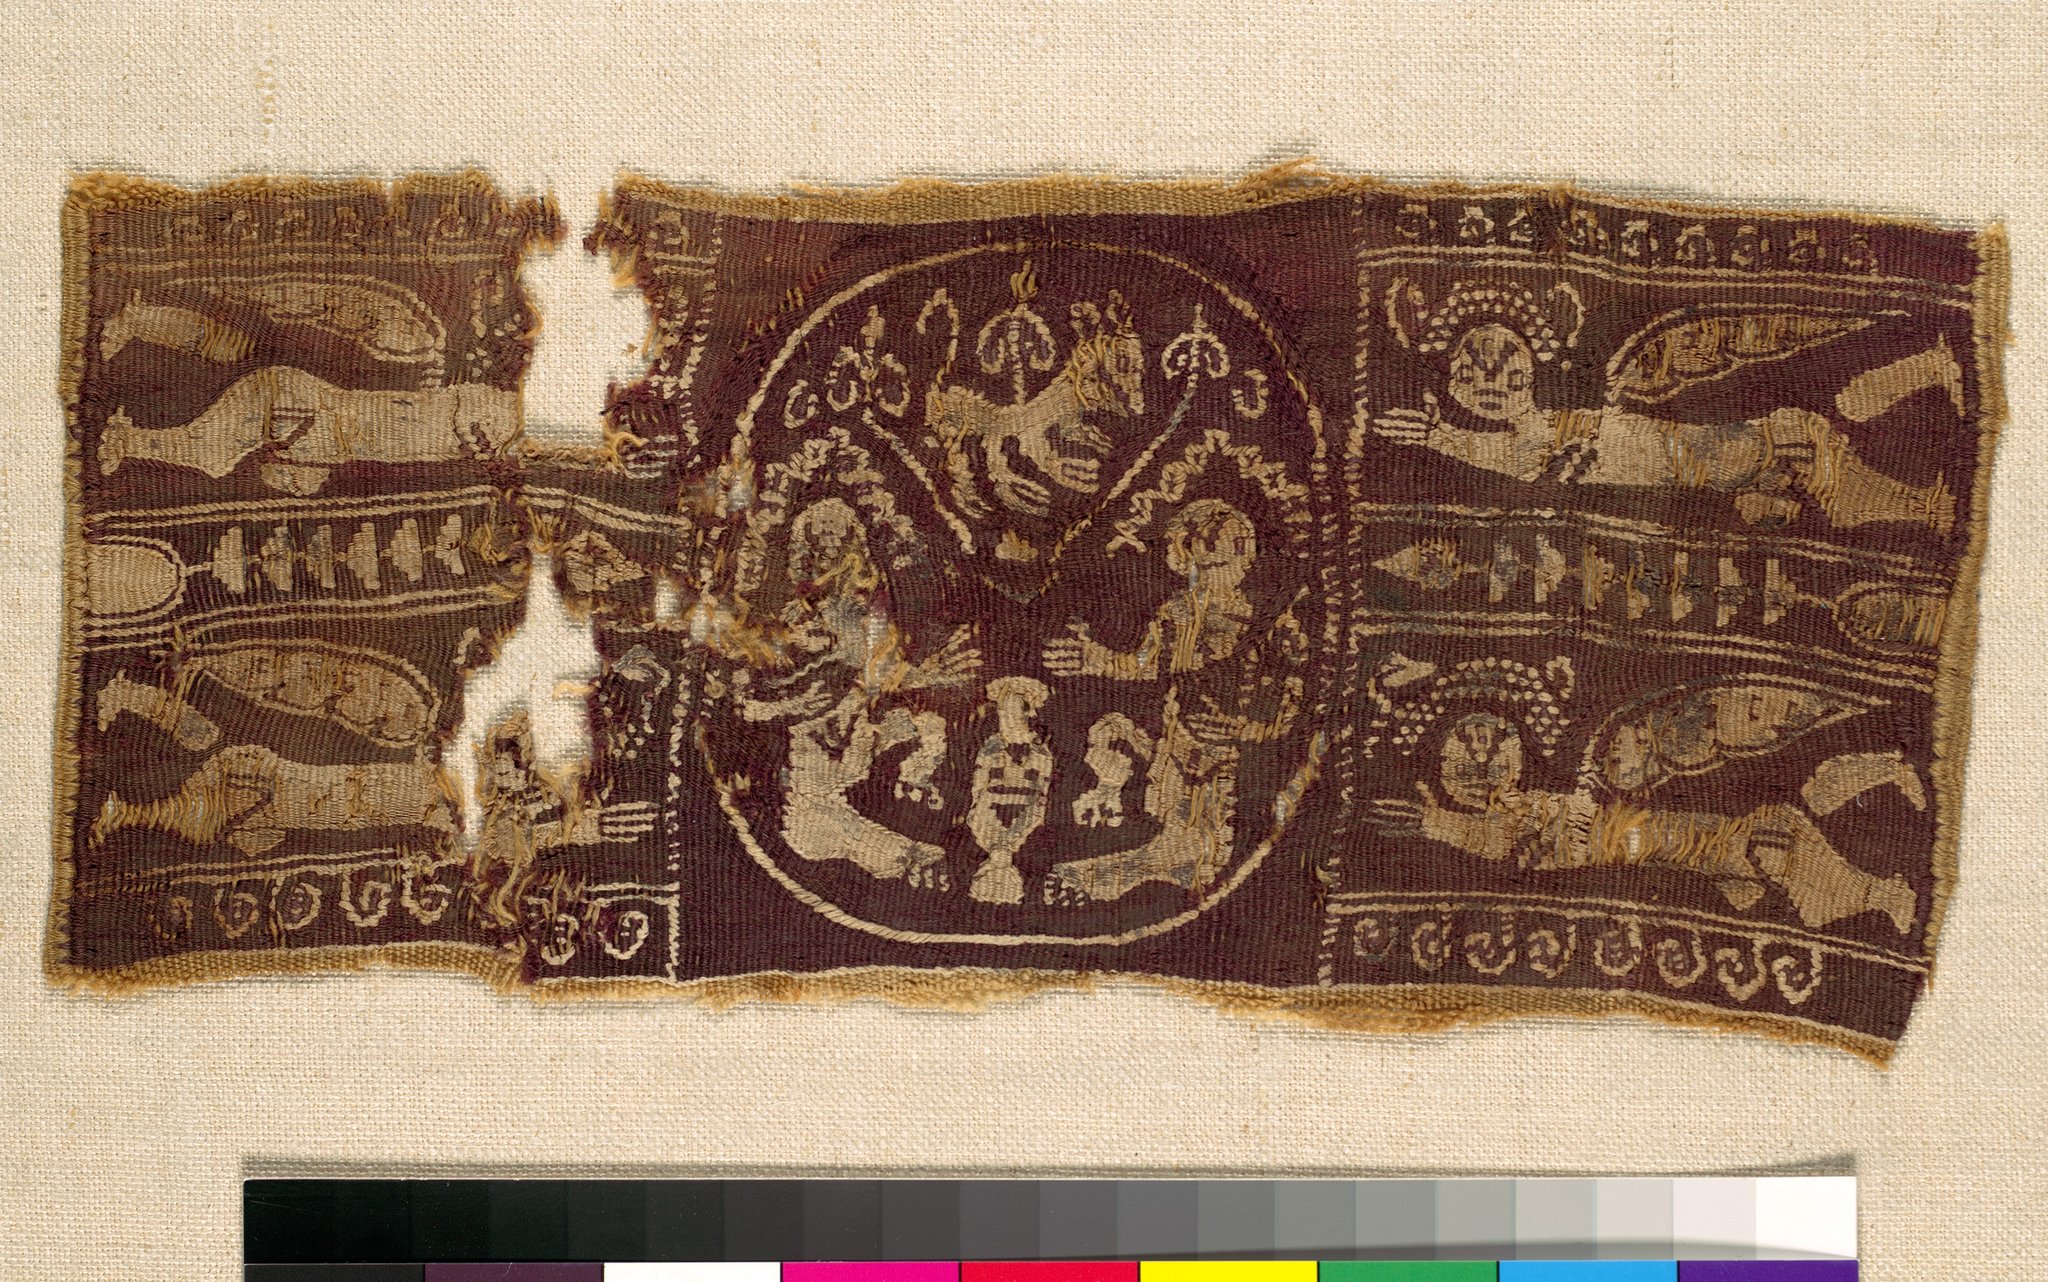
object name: textile fragment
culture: byzantine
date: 501-700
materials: linen, wool